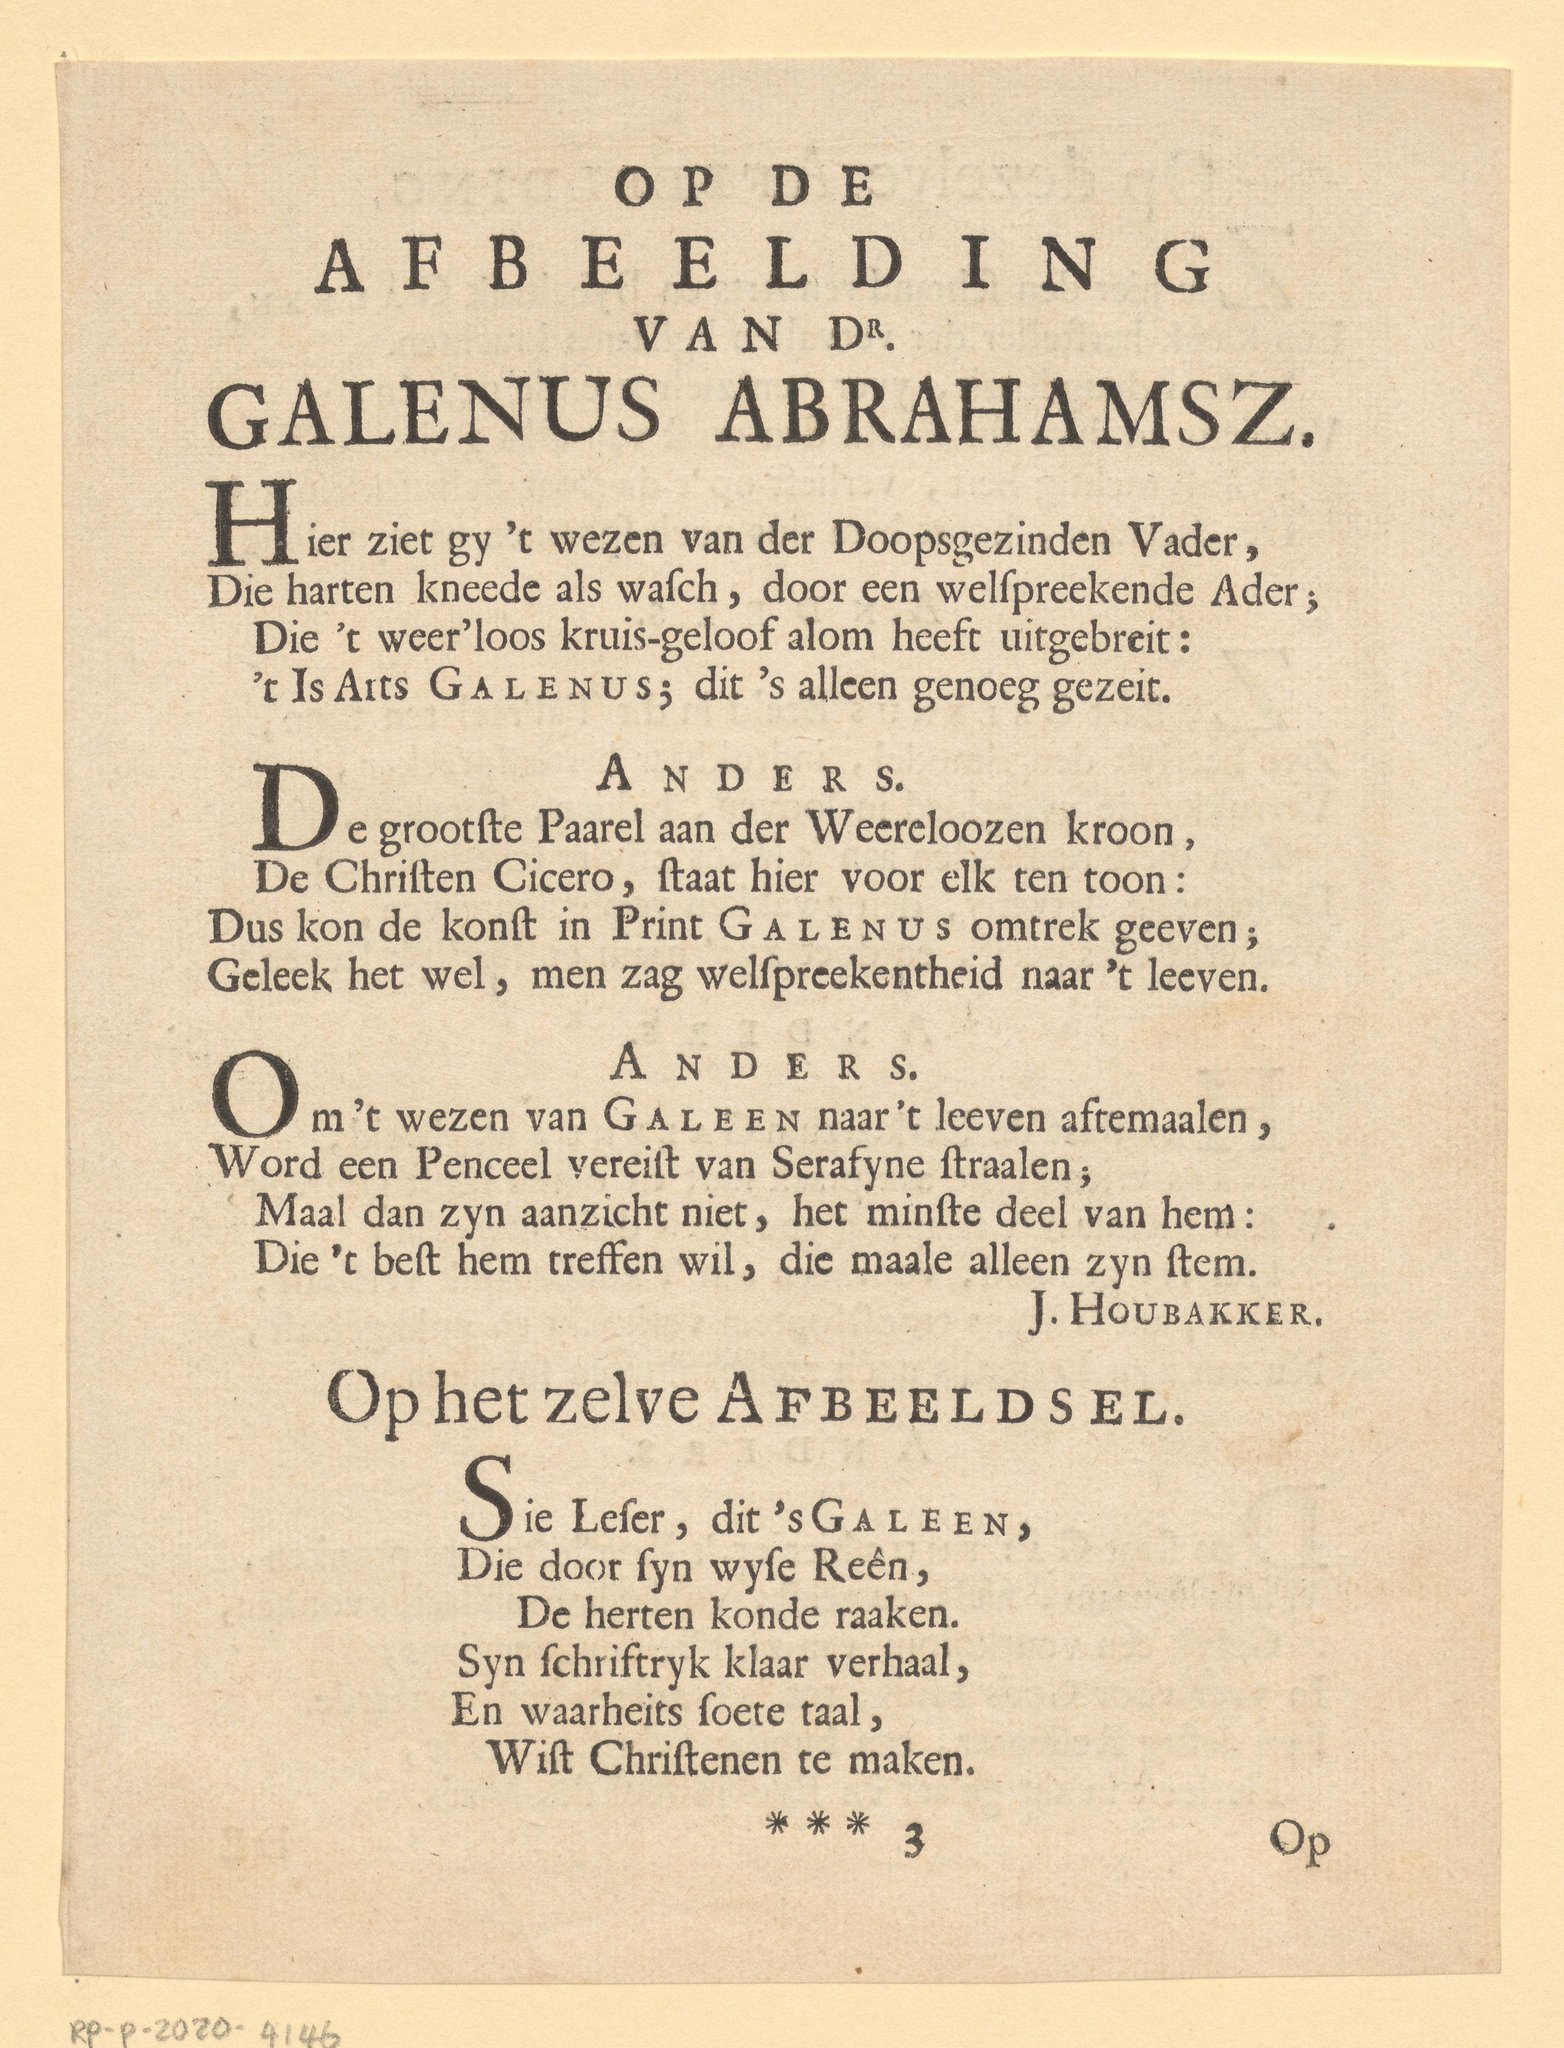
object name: text sheet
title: Bladzijde uit: Galenus Abrahamsz van den Haan, Eenige nagelaten schriften, 1707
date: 1707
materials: paper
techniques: letterpress printing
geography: amsterdam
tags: production of printed matter, book-production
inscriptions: : ‘Op de/ Afbeelding/ Van Dr./ Galenus Abrahamsz./ (...)’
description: Bladzijde uit: Haan, Galenus Abrahamsz van den. Eenige nagelaten schriften (...). Amsterdam: Cornelis van der Sys en weduwe Pieter (II) Arentsz, 1707.